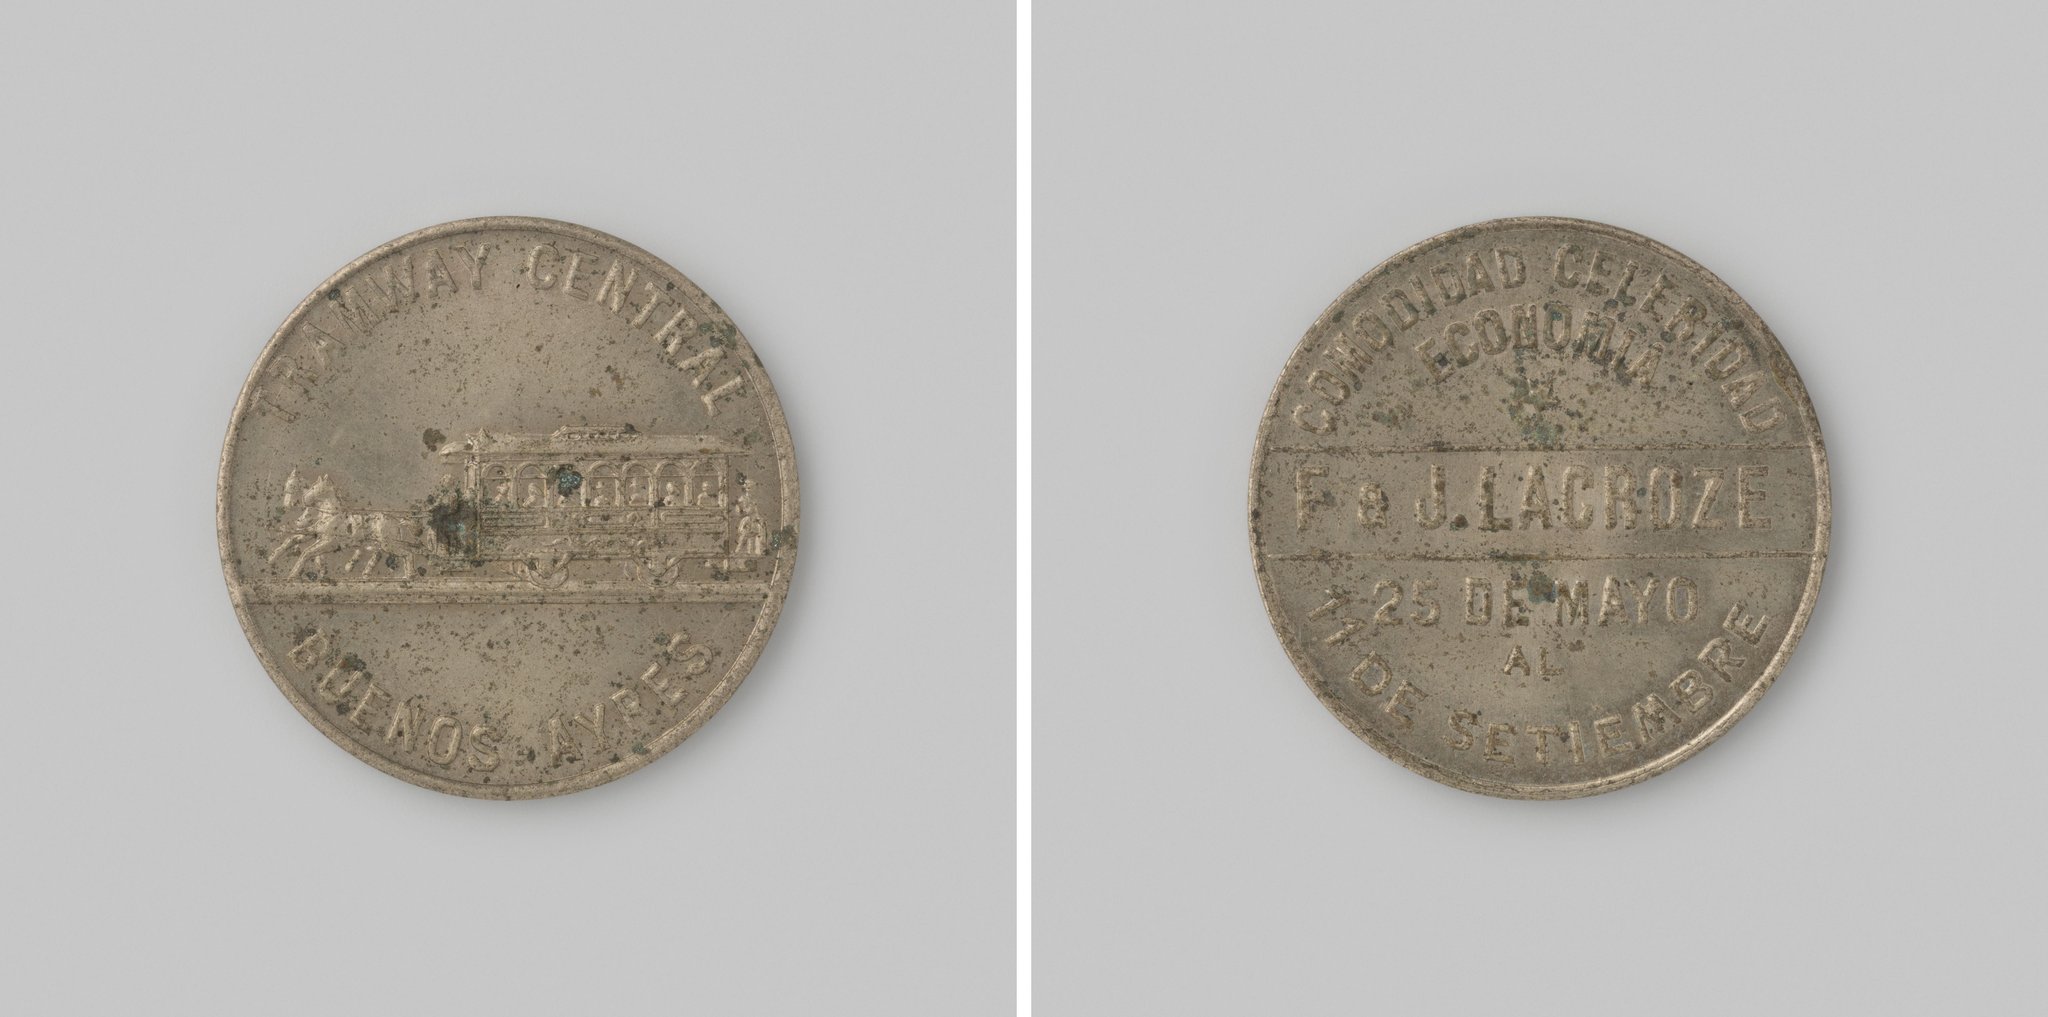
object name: history medal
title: Tramway Central Buenos Ayres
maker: Anonymous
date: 1870-1885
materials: alloy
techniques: striking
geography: buenos aires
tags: j. lacroze, f. lacroze, buenos aires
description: Penning. Voorzijde: paardentram binnen omschrift. Keerzijde: opschrift in band binnen omschrift